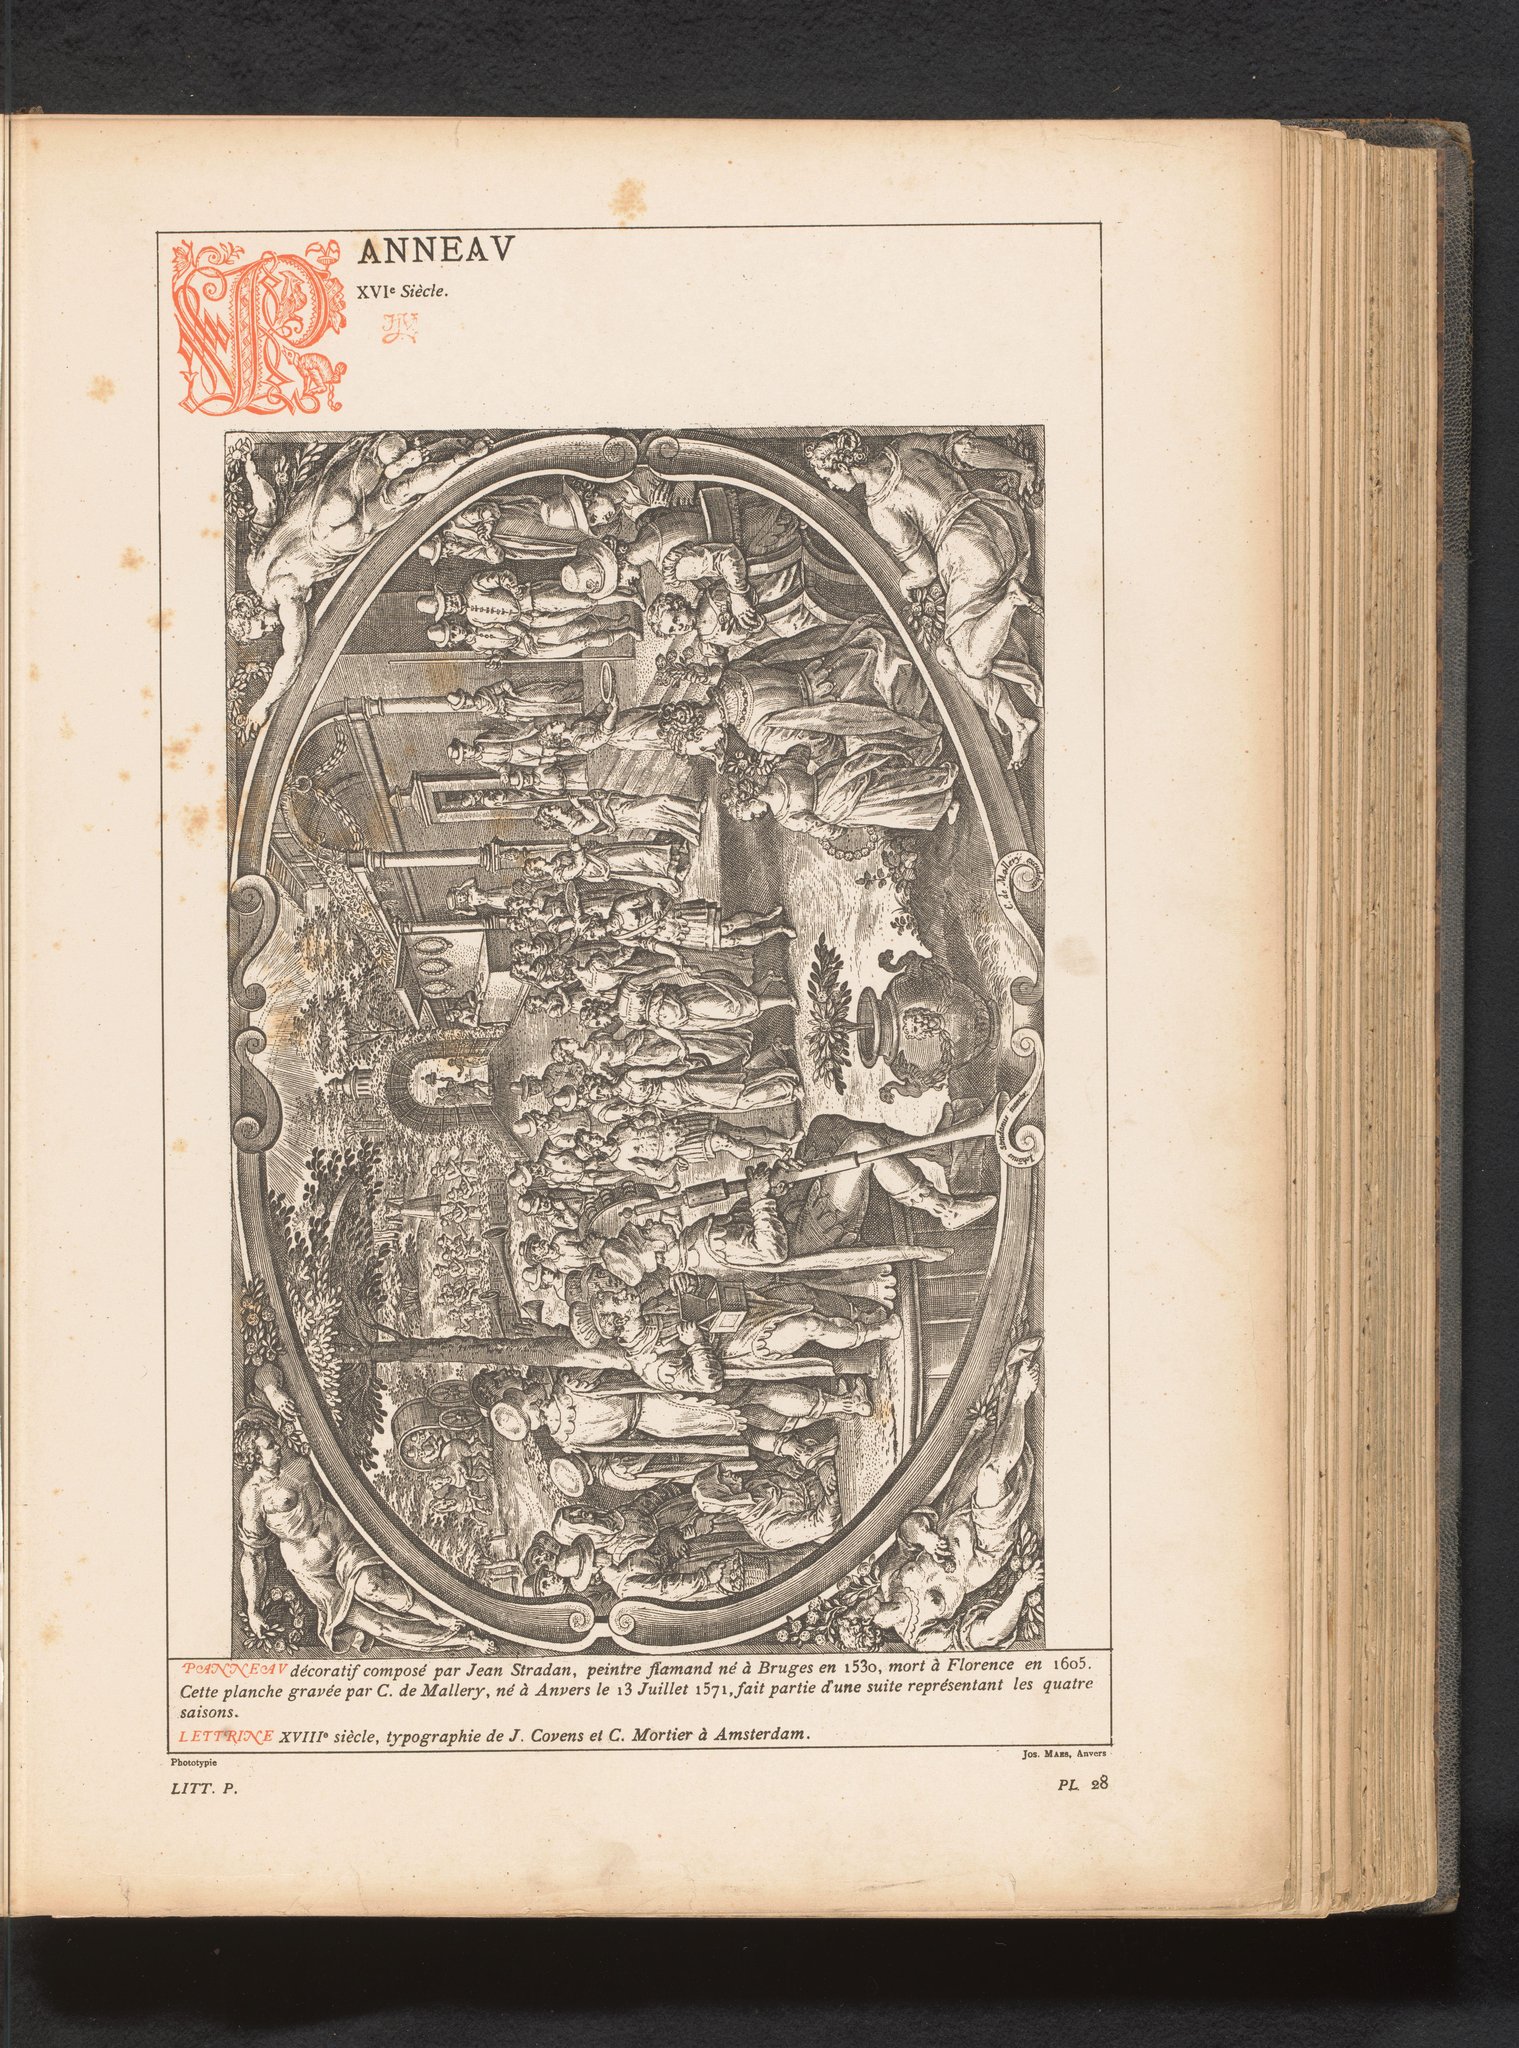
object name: photomechanical print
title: Panneau, XVIe Siècle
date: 1876-1881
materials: paper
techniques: photolithography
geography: amsterdam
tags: print, e.g.: engraving, etching, lithograph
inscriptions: inscription: ‘PANNEAU décoratif composé (...)’, inscription: ‘LITT. P. - PL. 28.’, monogram: ‘JJvY’